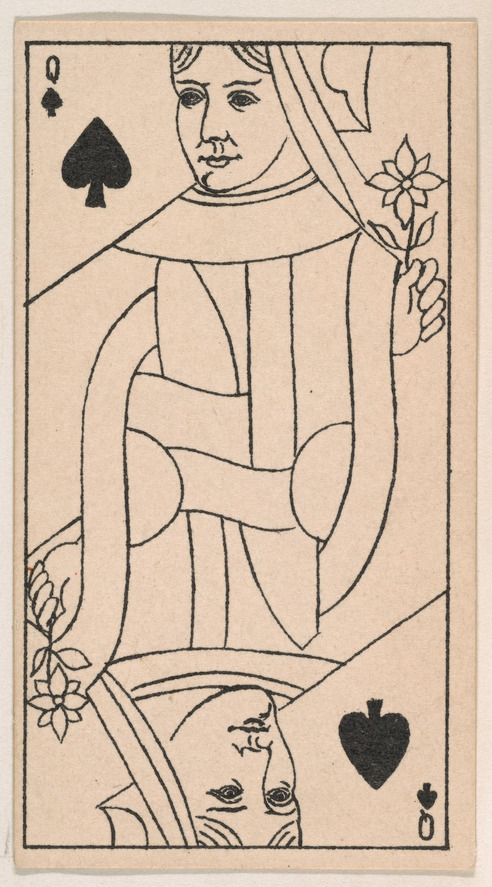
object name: print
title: Queen of Spades, from the Transparent Playing Cards series (N220) issued by Kinney Bros.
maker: kinney brothers tobacco company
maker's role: publisher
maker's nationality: american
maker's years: 1869-2011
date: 1888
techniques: color lithograph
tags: queens,playing cards